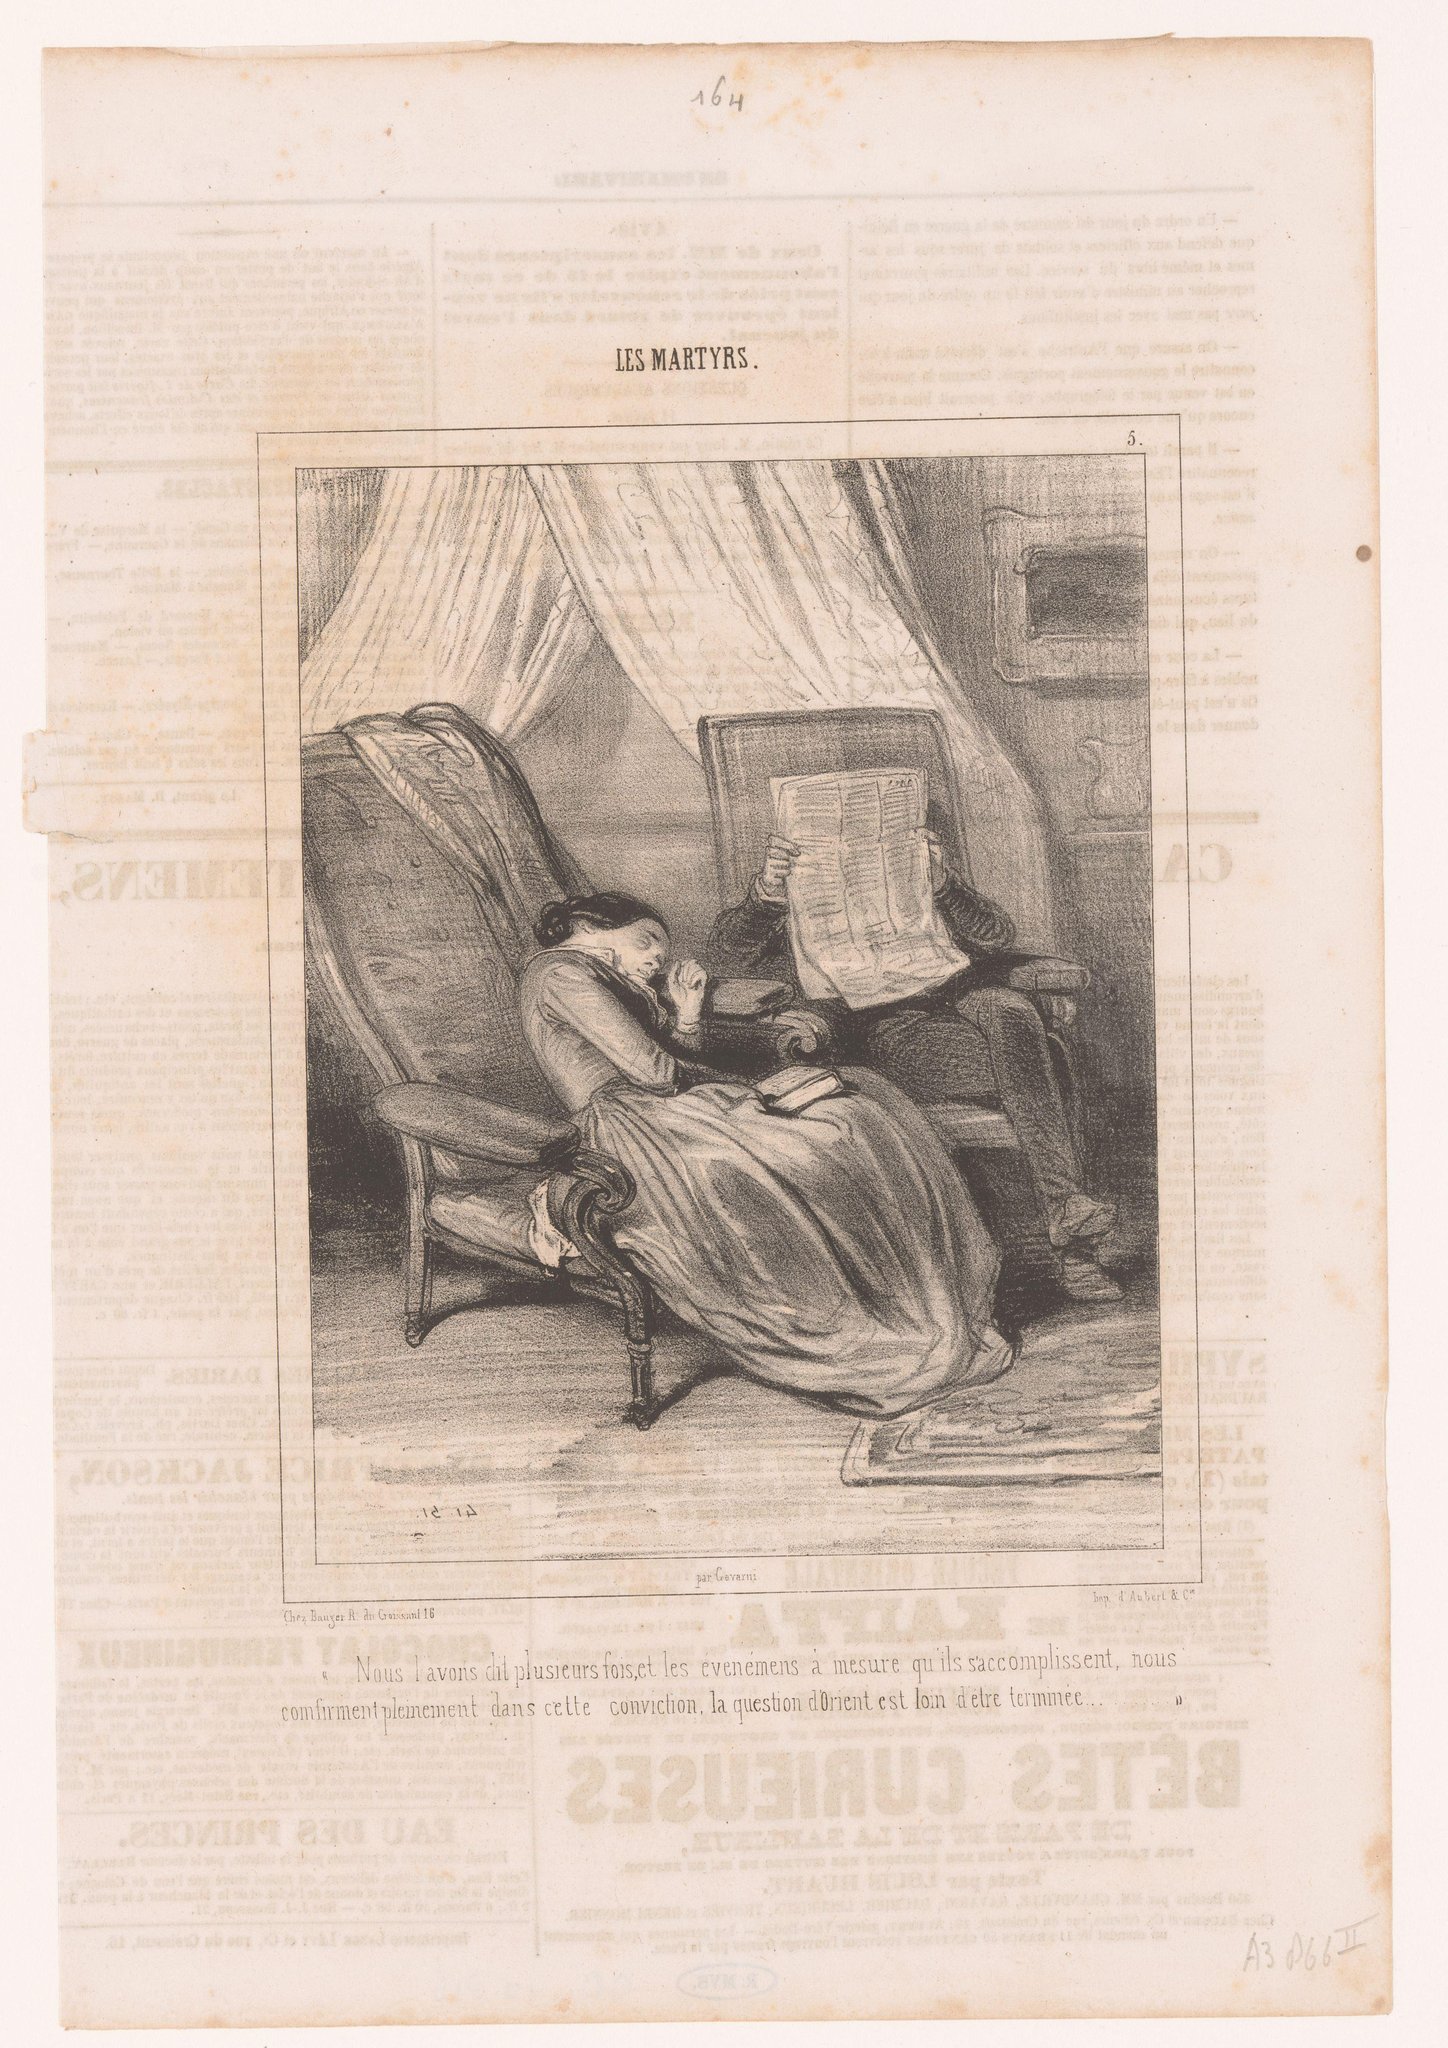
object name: print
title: Nous l'avons dit plusieurs fois (...)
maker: paul gavarni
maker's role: draughtsman, print maker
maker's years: 1804-1866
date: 1841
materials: paper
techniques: lithograph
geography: paris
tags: sleeping in chair, reading to somebody, newspaper, news-sheet, satire on marriage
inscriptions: collector's mark: Lugt 2228a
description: Prent gebruikt voor: Le Charivari, 12 juli 1841.